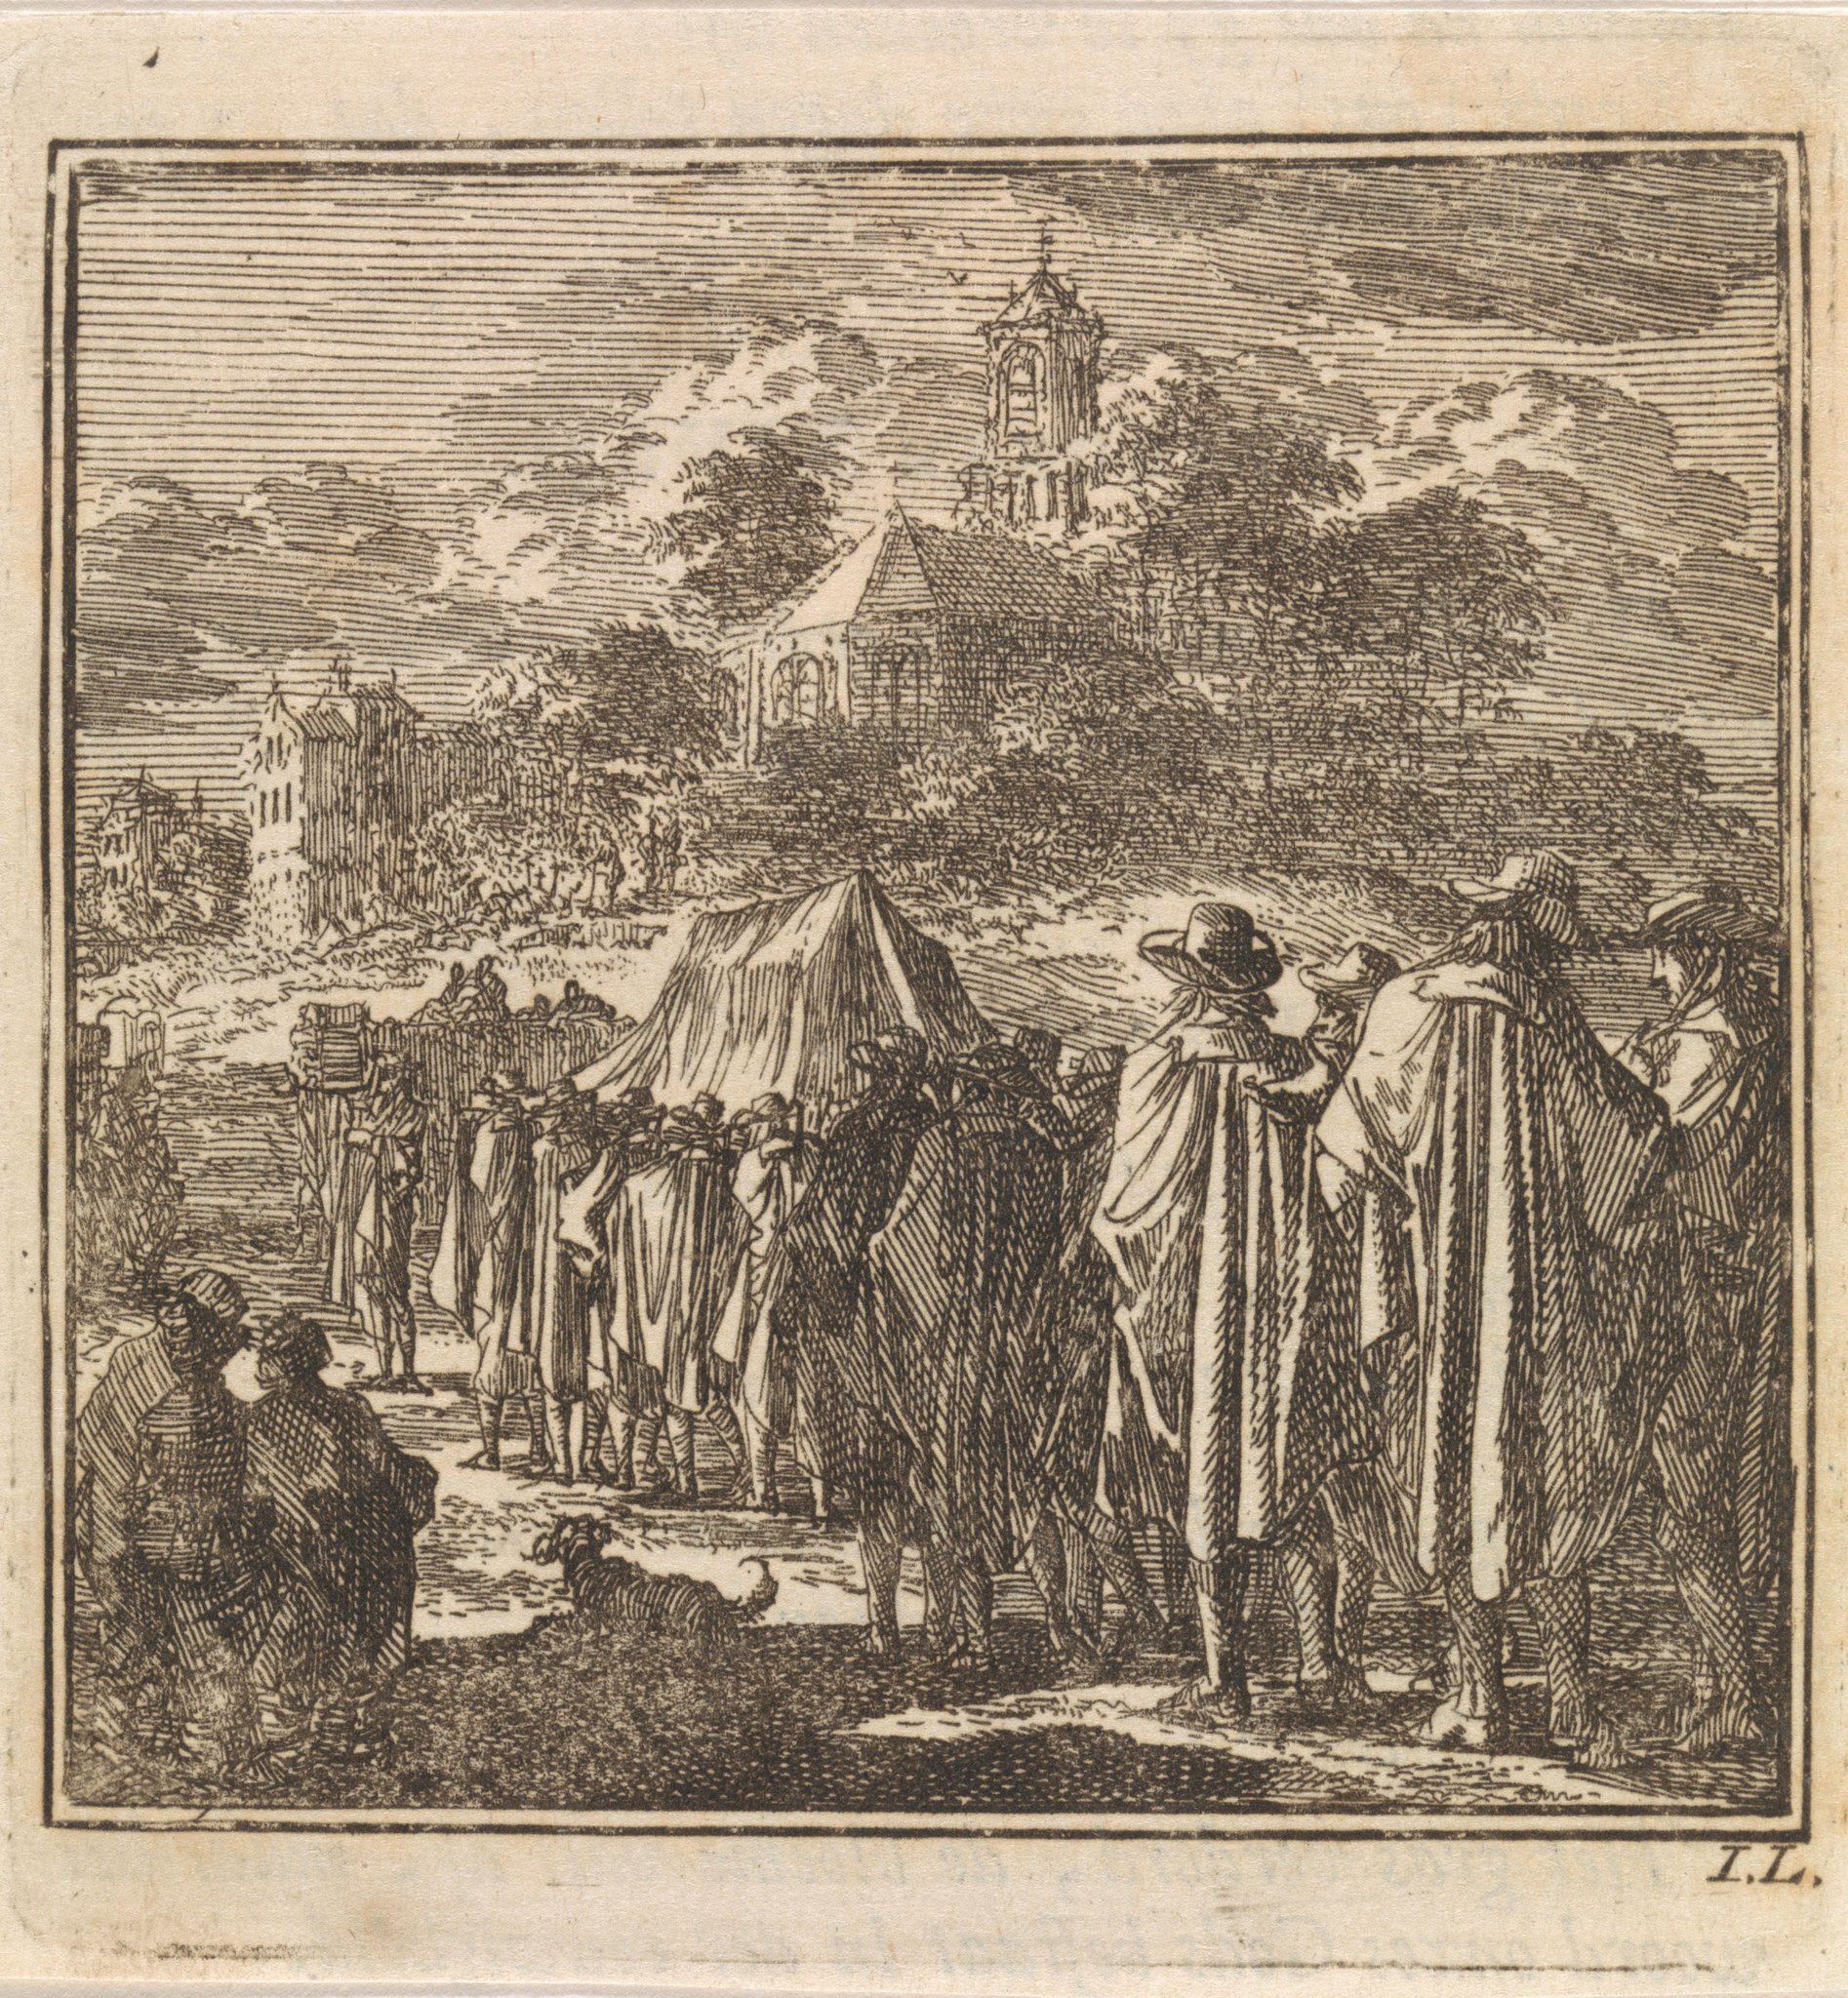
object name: print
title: De Begrafenis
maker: jan luyken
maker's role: draughtsman, print maker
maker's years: 1649-1712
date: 1711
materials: paper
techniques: etching, letterpress printing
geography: amsterdam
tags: cortege, funeral procession, church (exterior)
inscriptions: collector's mark: Lugt 2228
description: Illustratie voor: Luyken, Jan. De Bykorf des Gemoeds. Amsterdam: Pieter Arentsz. II (wed.) en Cornelis van der Sys, 1711, p. 402.